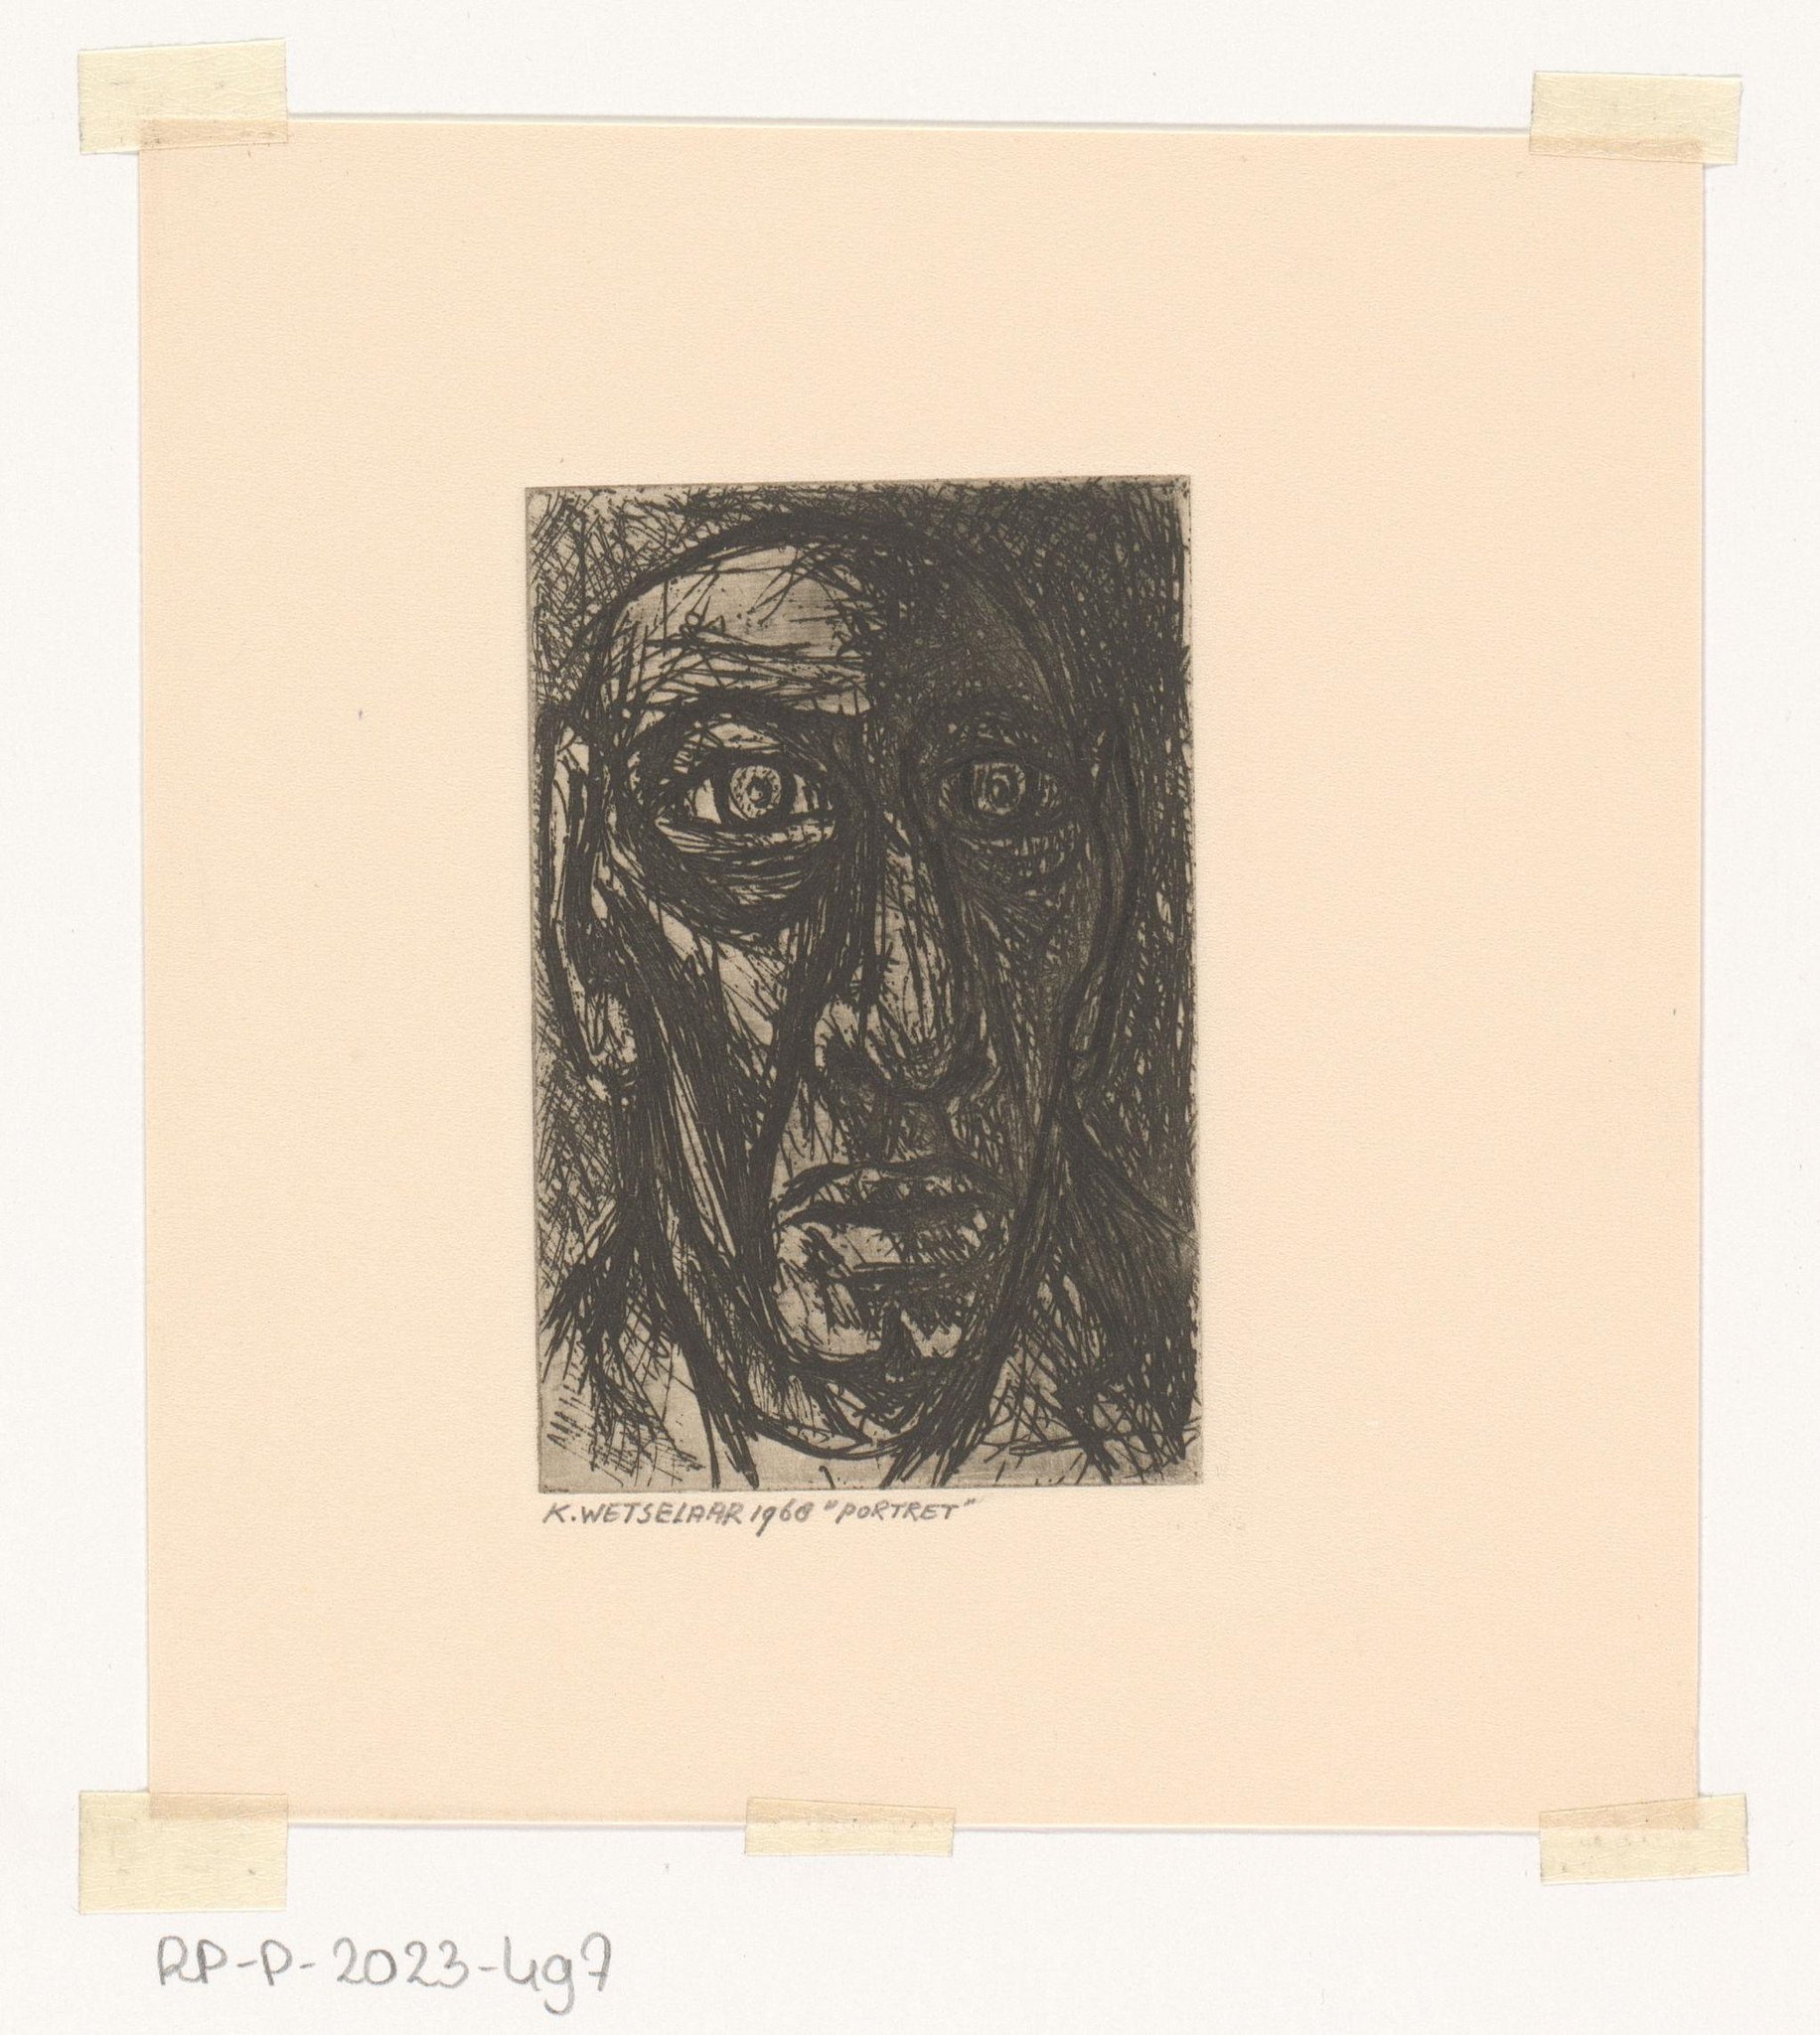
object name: print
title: Portret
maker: karel wetselaar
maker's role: print maker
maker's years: 1935-2017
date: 1968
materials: paper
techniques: etching, intaglio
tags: historical persons not known by name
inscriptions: signature and date: ‘K. Wetselaar 1968’